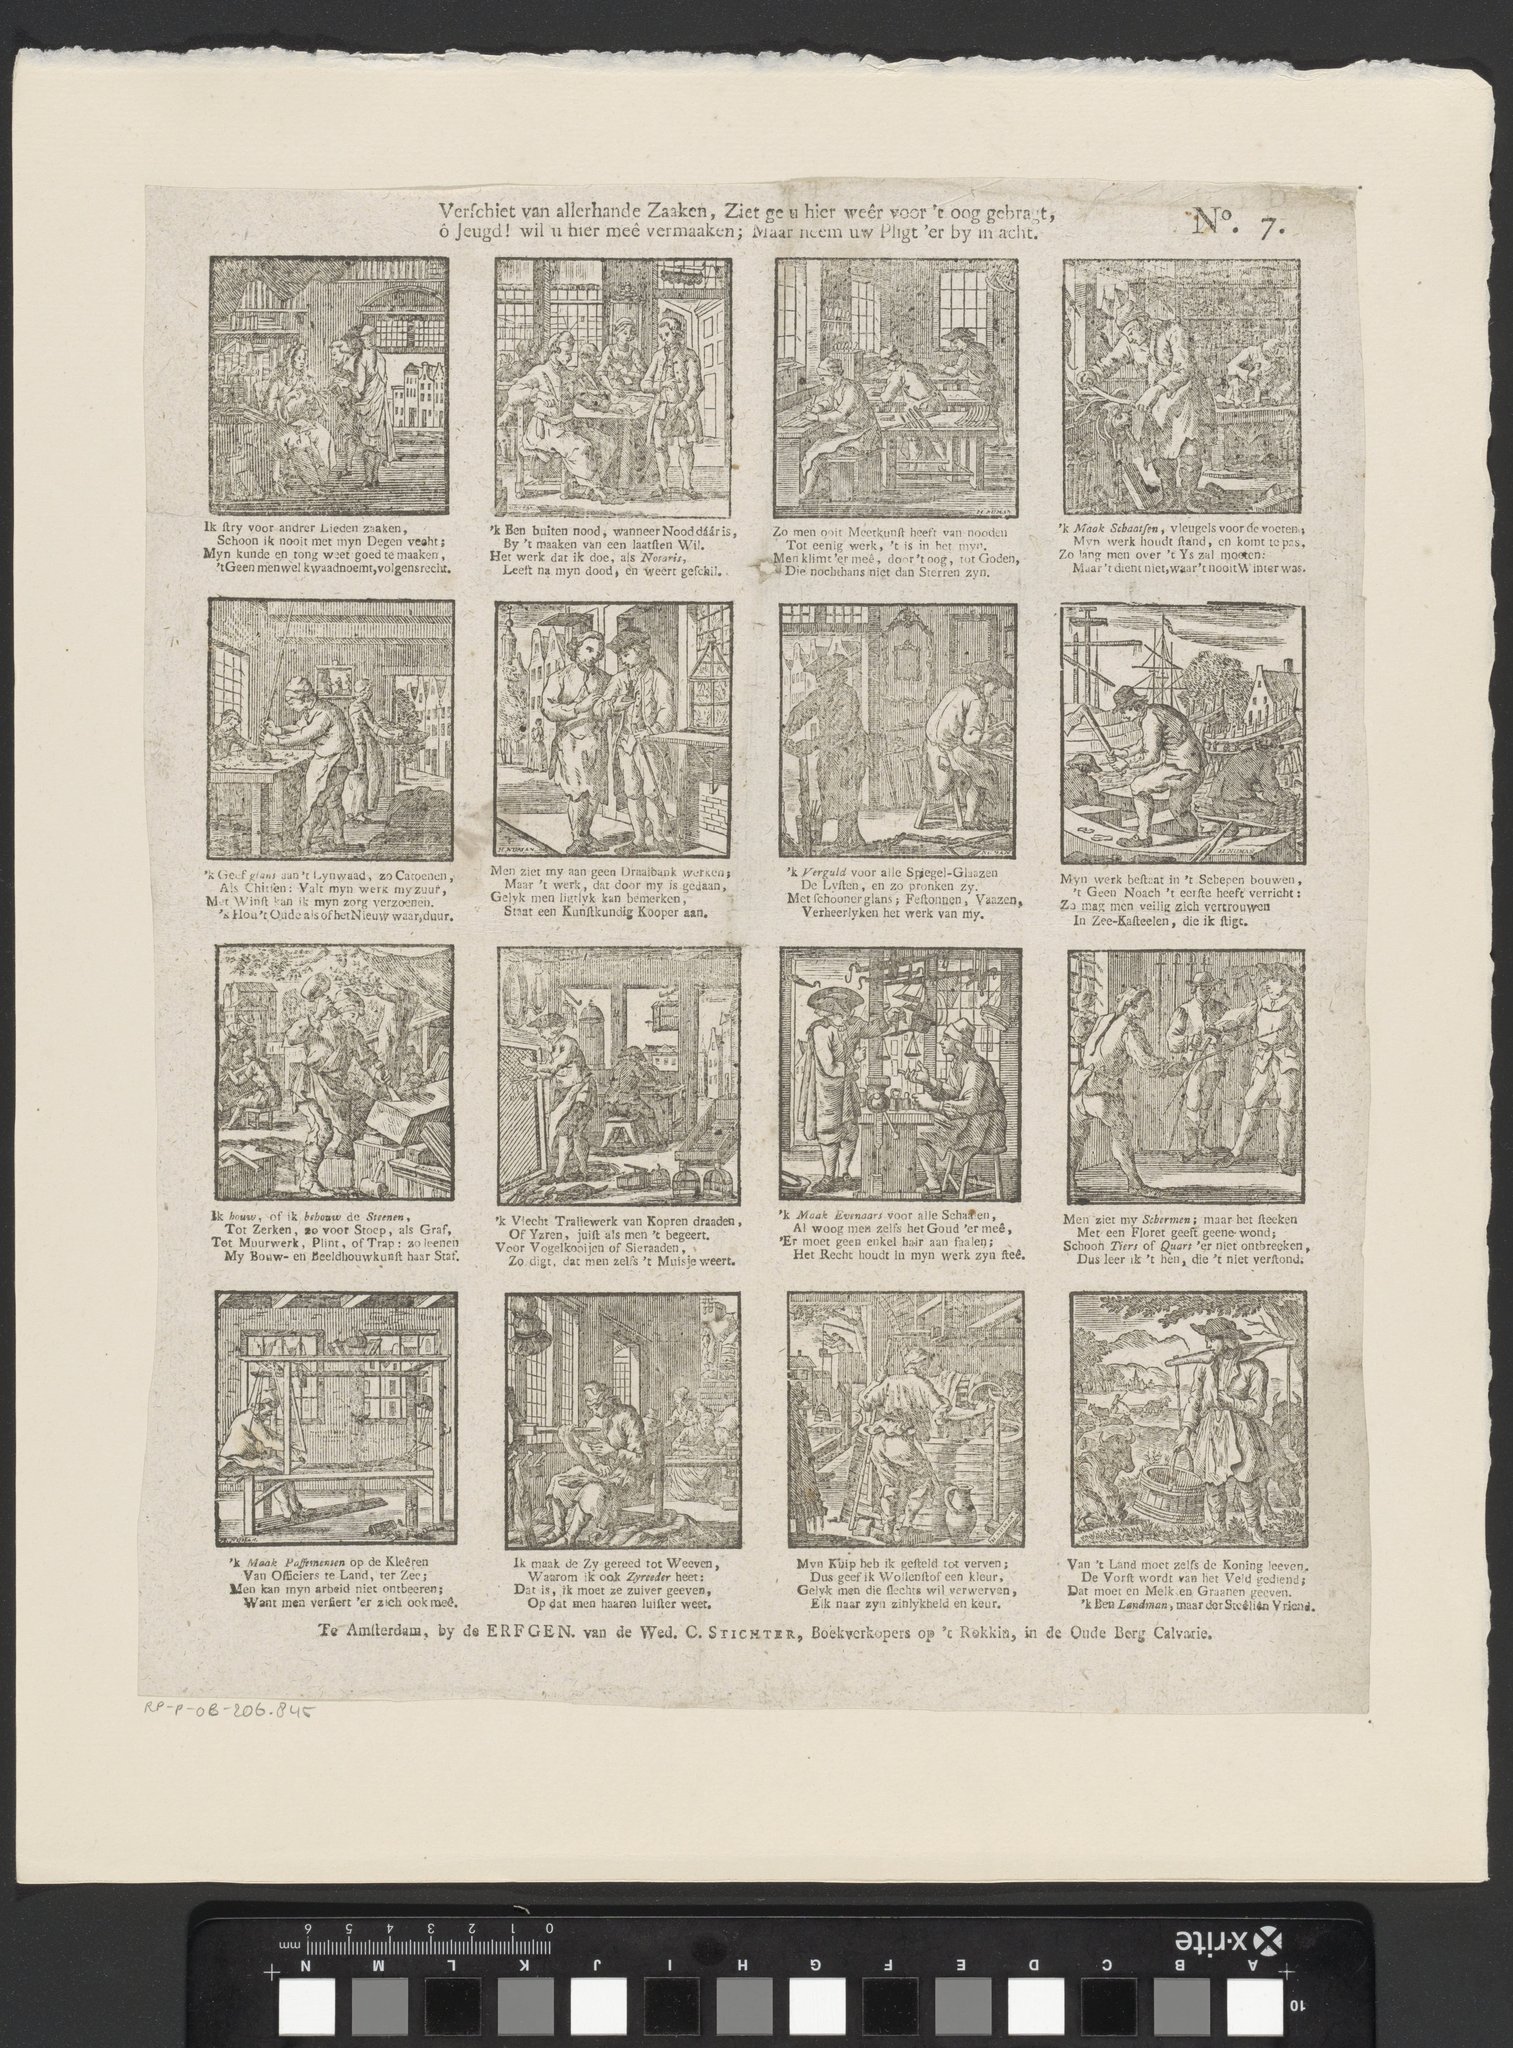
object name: popular print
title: Verschiet van allerhande zaaken, Ziet ge u hier weêr voor 't oog gebragt, / ô Jeugd! wil u hier meê vermaaken; Maar neem uw pligt 'er by in acht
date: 1715-1813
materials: paper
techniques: letterpress printing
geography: amsterdam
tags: craft-production, skilled handiwork, crafts and industries, merchant, salesman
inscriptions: collector's mark: Lugt 2760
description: Blad met 16 voorstellingen van ambachtslieden en beroepen, zoals een notaris, een schaatsenmaker en een steenhouwer. Onder elke voorstelling een vierregelig vers. Genummerd rechtsboven: No. 7.